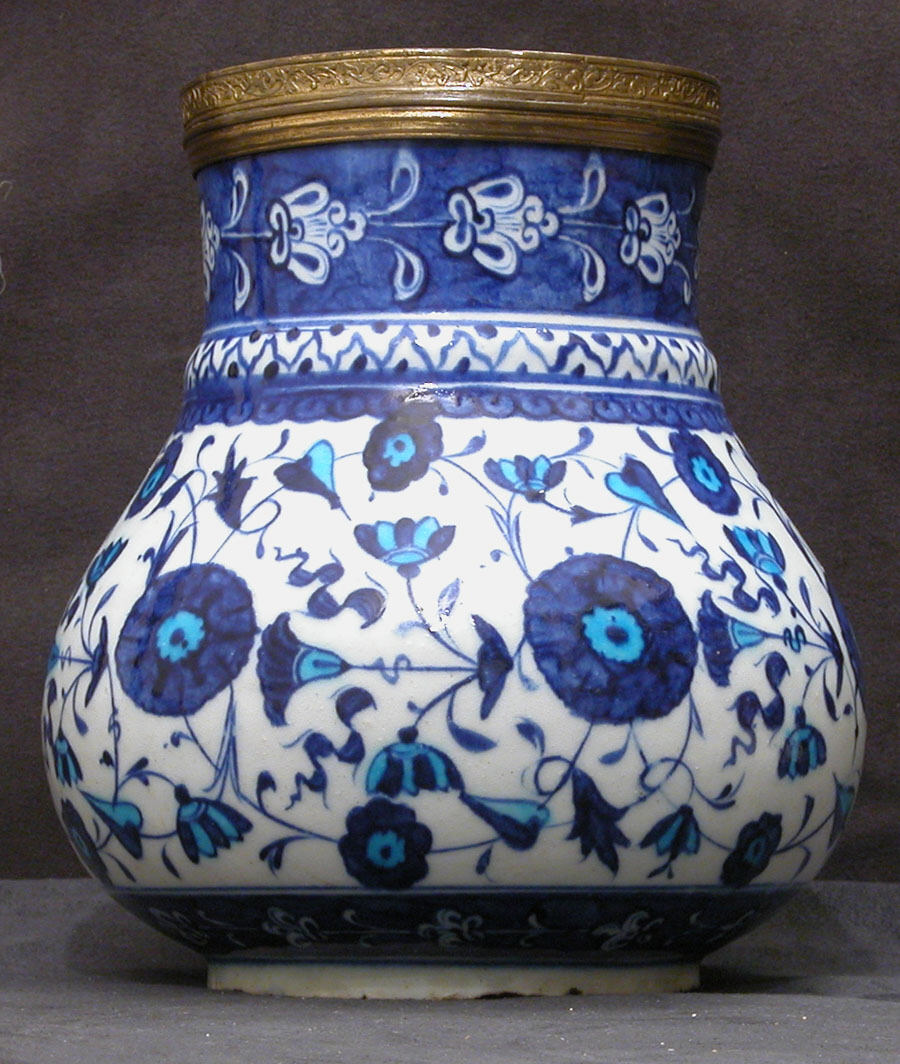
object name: vase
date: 1501-1550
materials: bronze, stonepaste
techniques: painting, underglaze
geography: turkey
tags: flowers